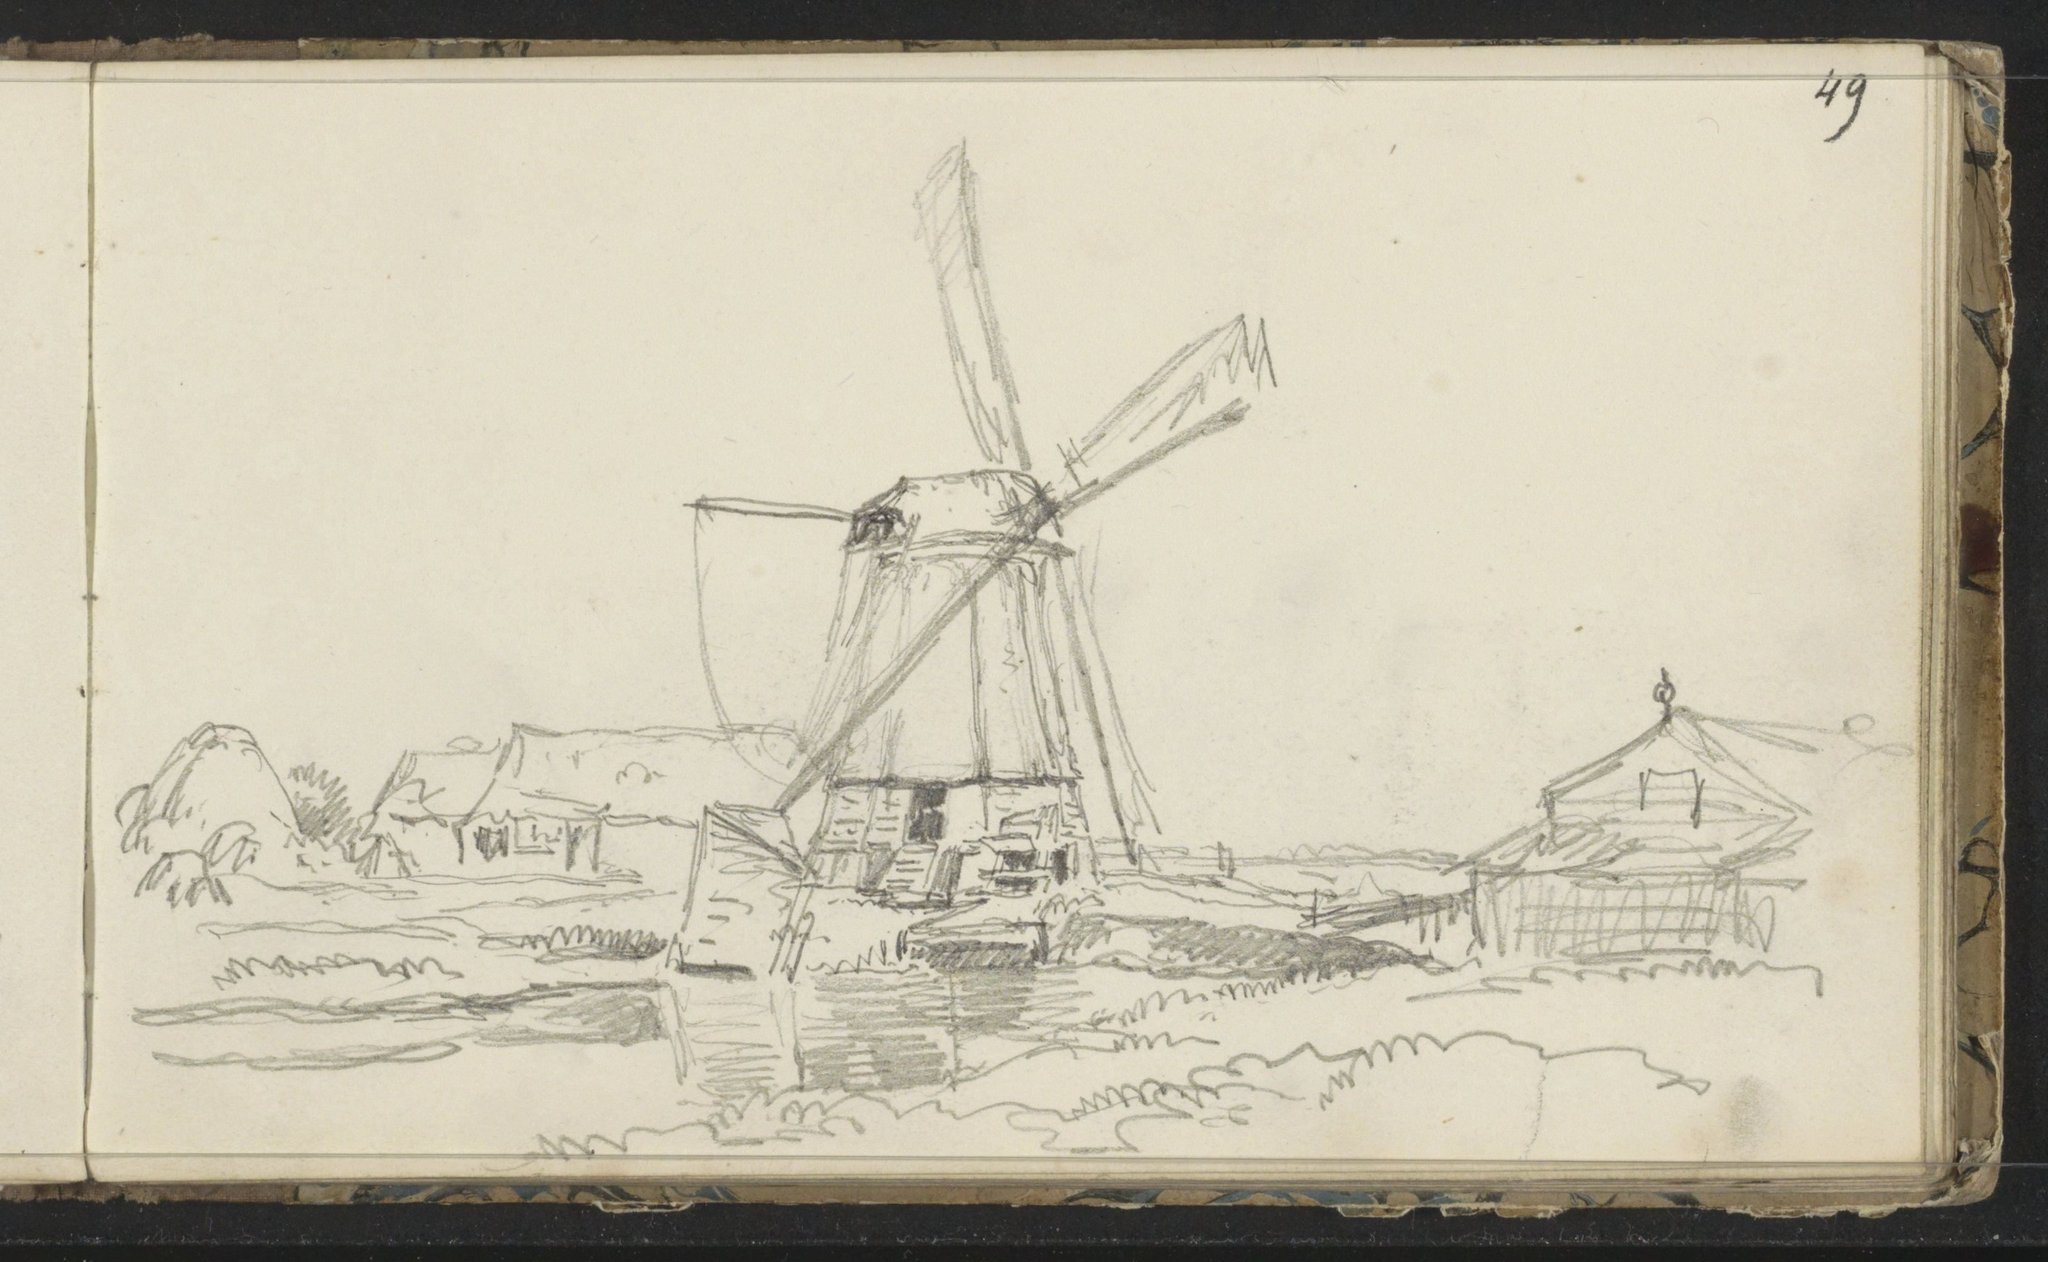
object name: sketchbook leaf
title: Landschap met een molen aan een waterkant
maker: arnoldus johannes eymer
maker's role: draughtsman, print maker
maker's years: 1803-1863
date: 1803-1818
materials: paper, pencil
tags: landscapes with waters, waterscapes, seascapes (in the temperate zone), windmill in landscape, farm (building)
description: Aan weerszijden van het water boerderijen. Bladzijde 49 uit een schetsboek met 74 bladzijden.